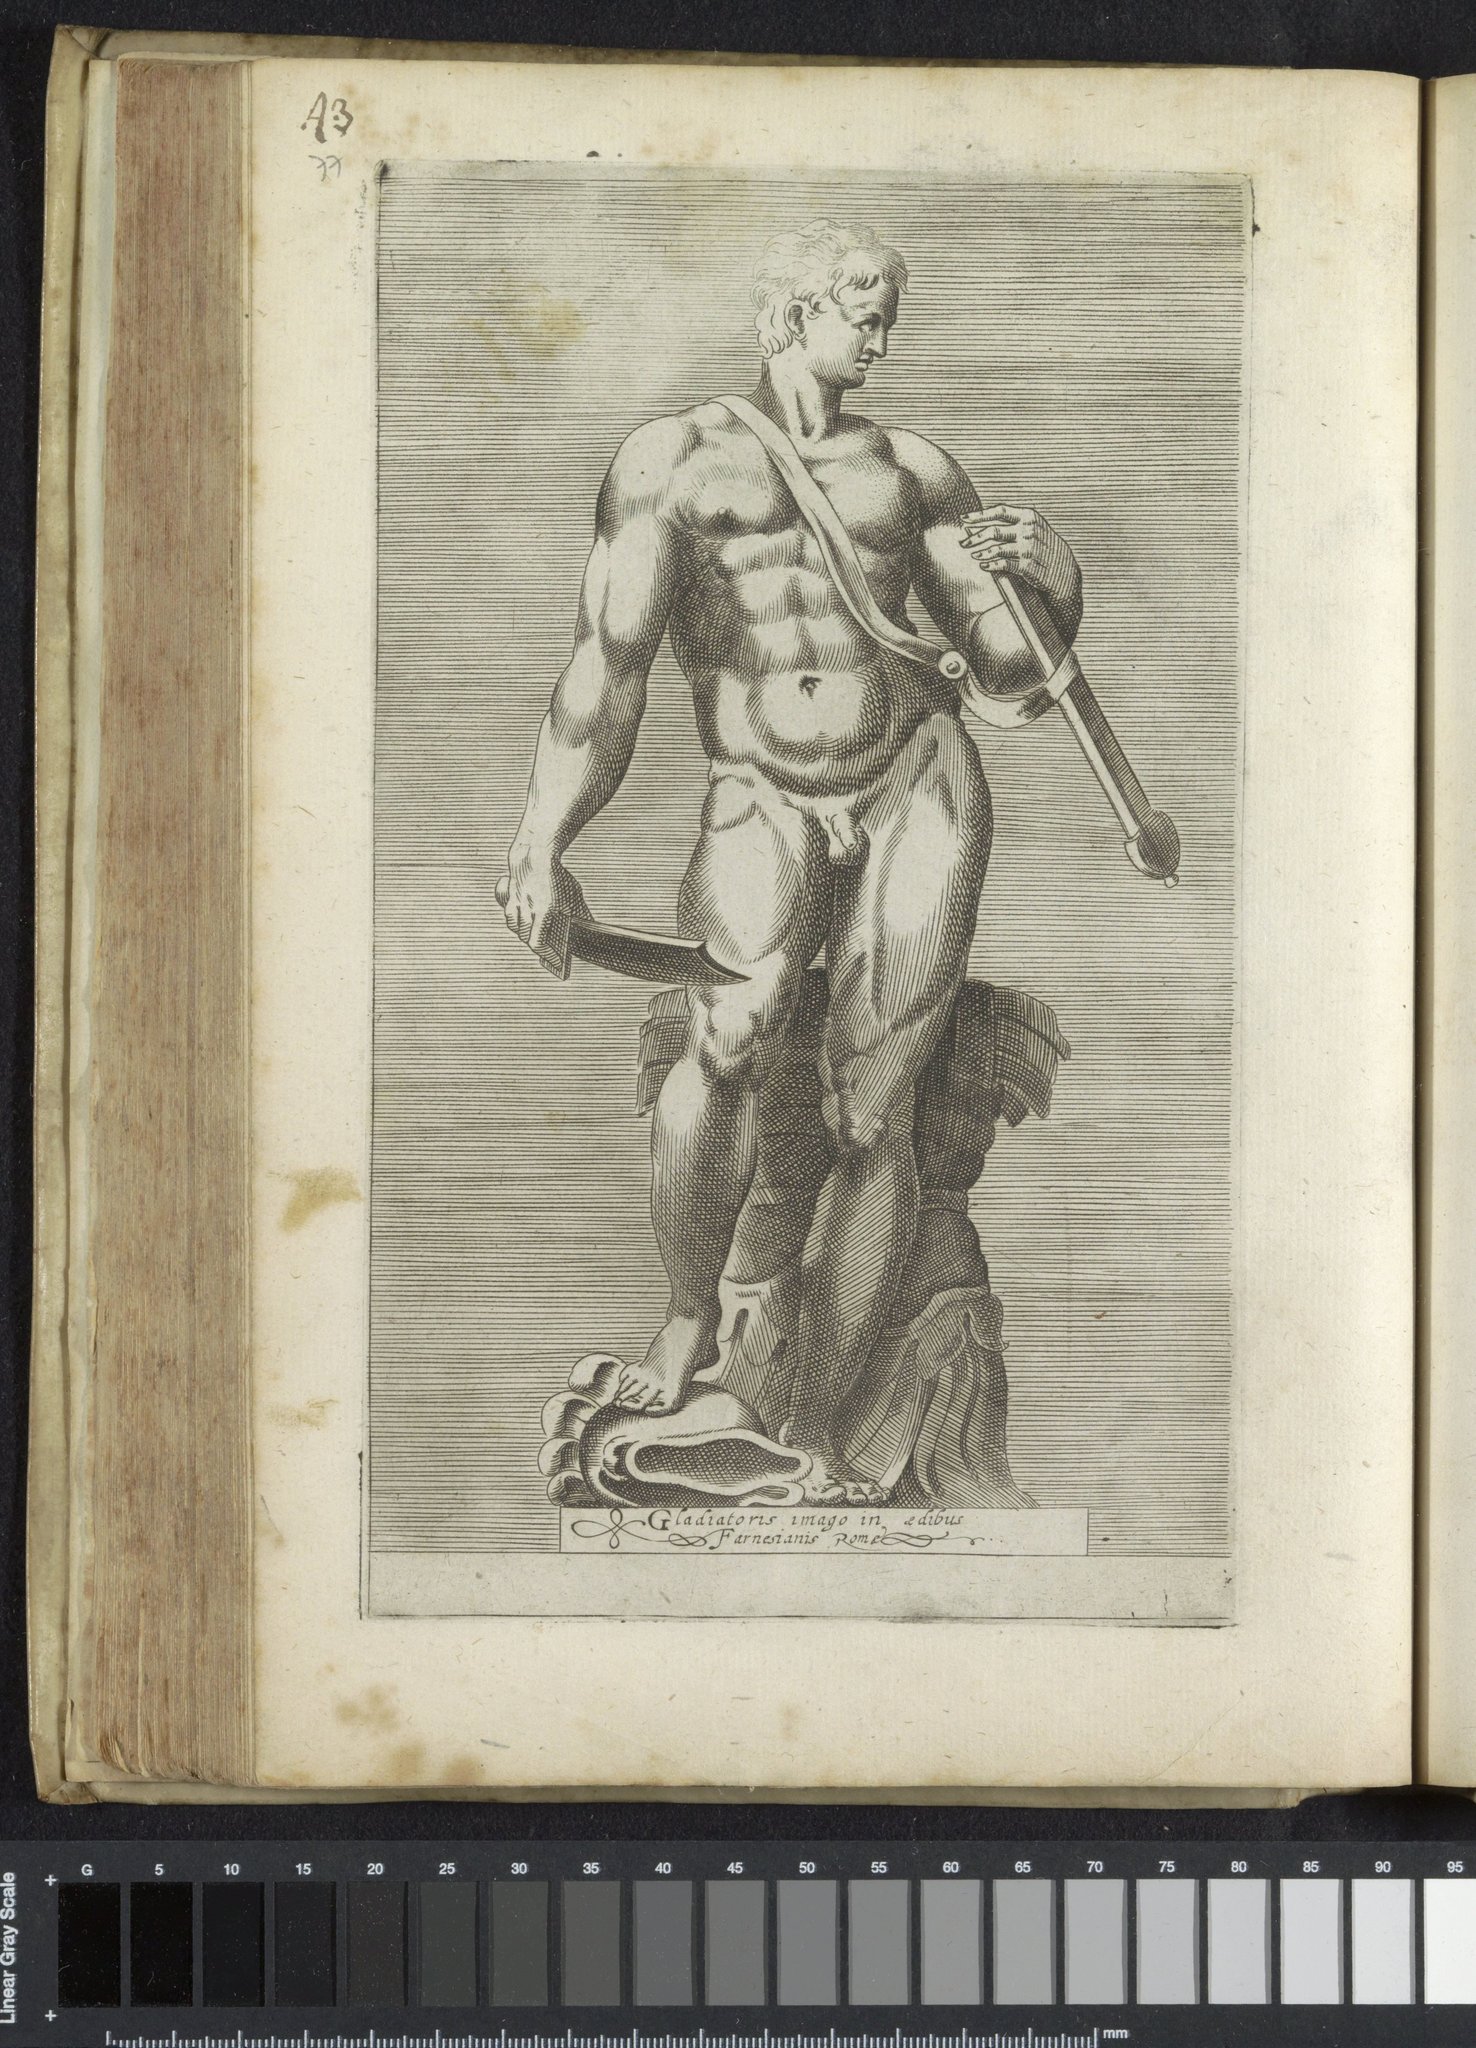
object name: print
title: Antieke sculpturen in Rome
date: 1584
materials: paper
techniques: engraving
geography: rome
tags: fight of gladiators, piece of sculpture, reproduction of a piece of sculpture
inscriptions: number: ‘43’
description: Deze prent maakt deel uit van een set van 79 prenten (+ titelprent) met voorstellingen van antieke sculpturen in Rome.